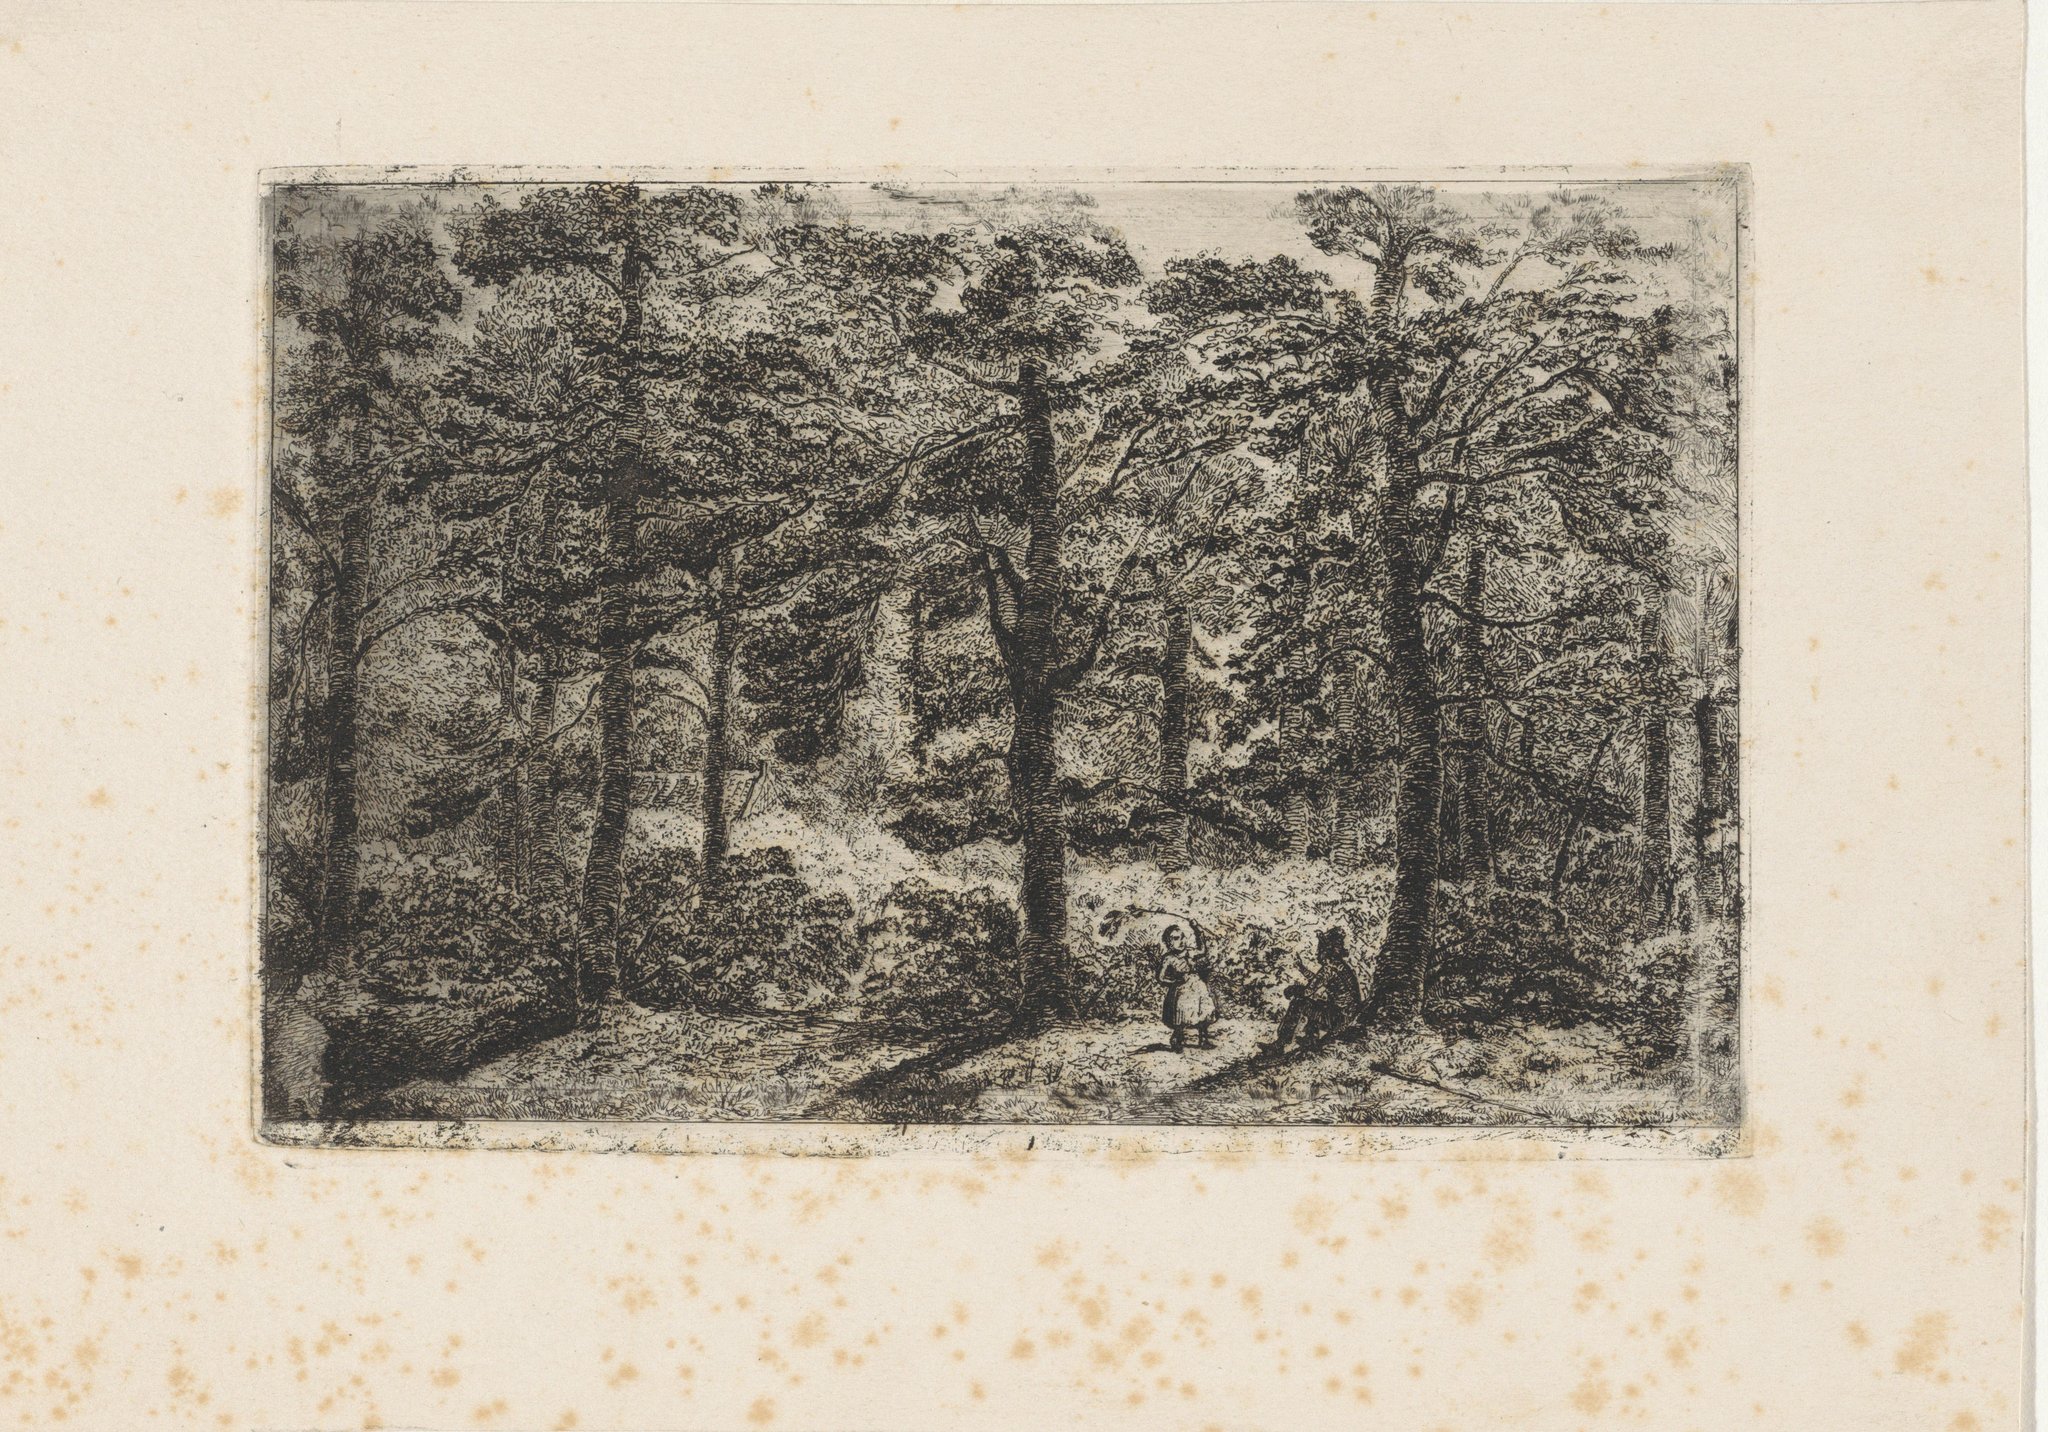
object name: print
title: Man met een kind in het bos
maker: louis charles hora siccama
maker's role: draughtsman, print maker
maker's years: 1807-1880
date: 1875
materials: paper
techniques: drypoint, etching, intaglio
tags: playing in the woods, zeist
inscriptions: collector's mark: Lugt 2228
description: Een man zit in het bos op de grond. Hij heft waarschuwend zijn vinger naar een meisje dat voor hem met een tak zwaait. Links is tussen de bomen het dak van een klein huis te zien.